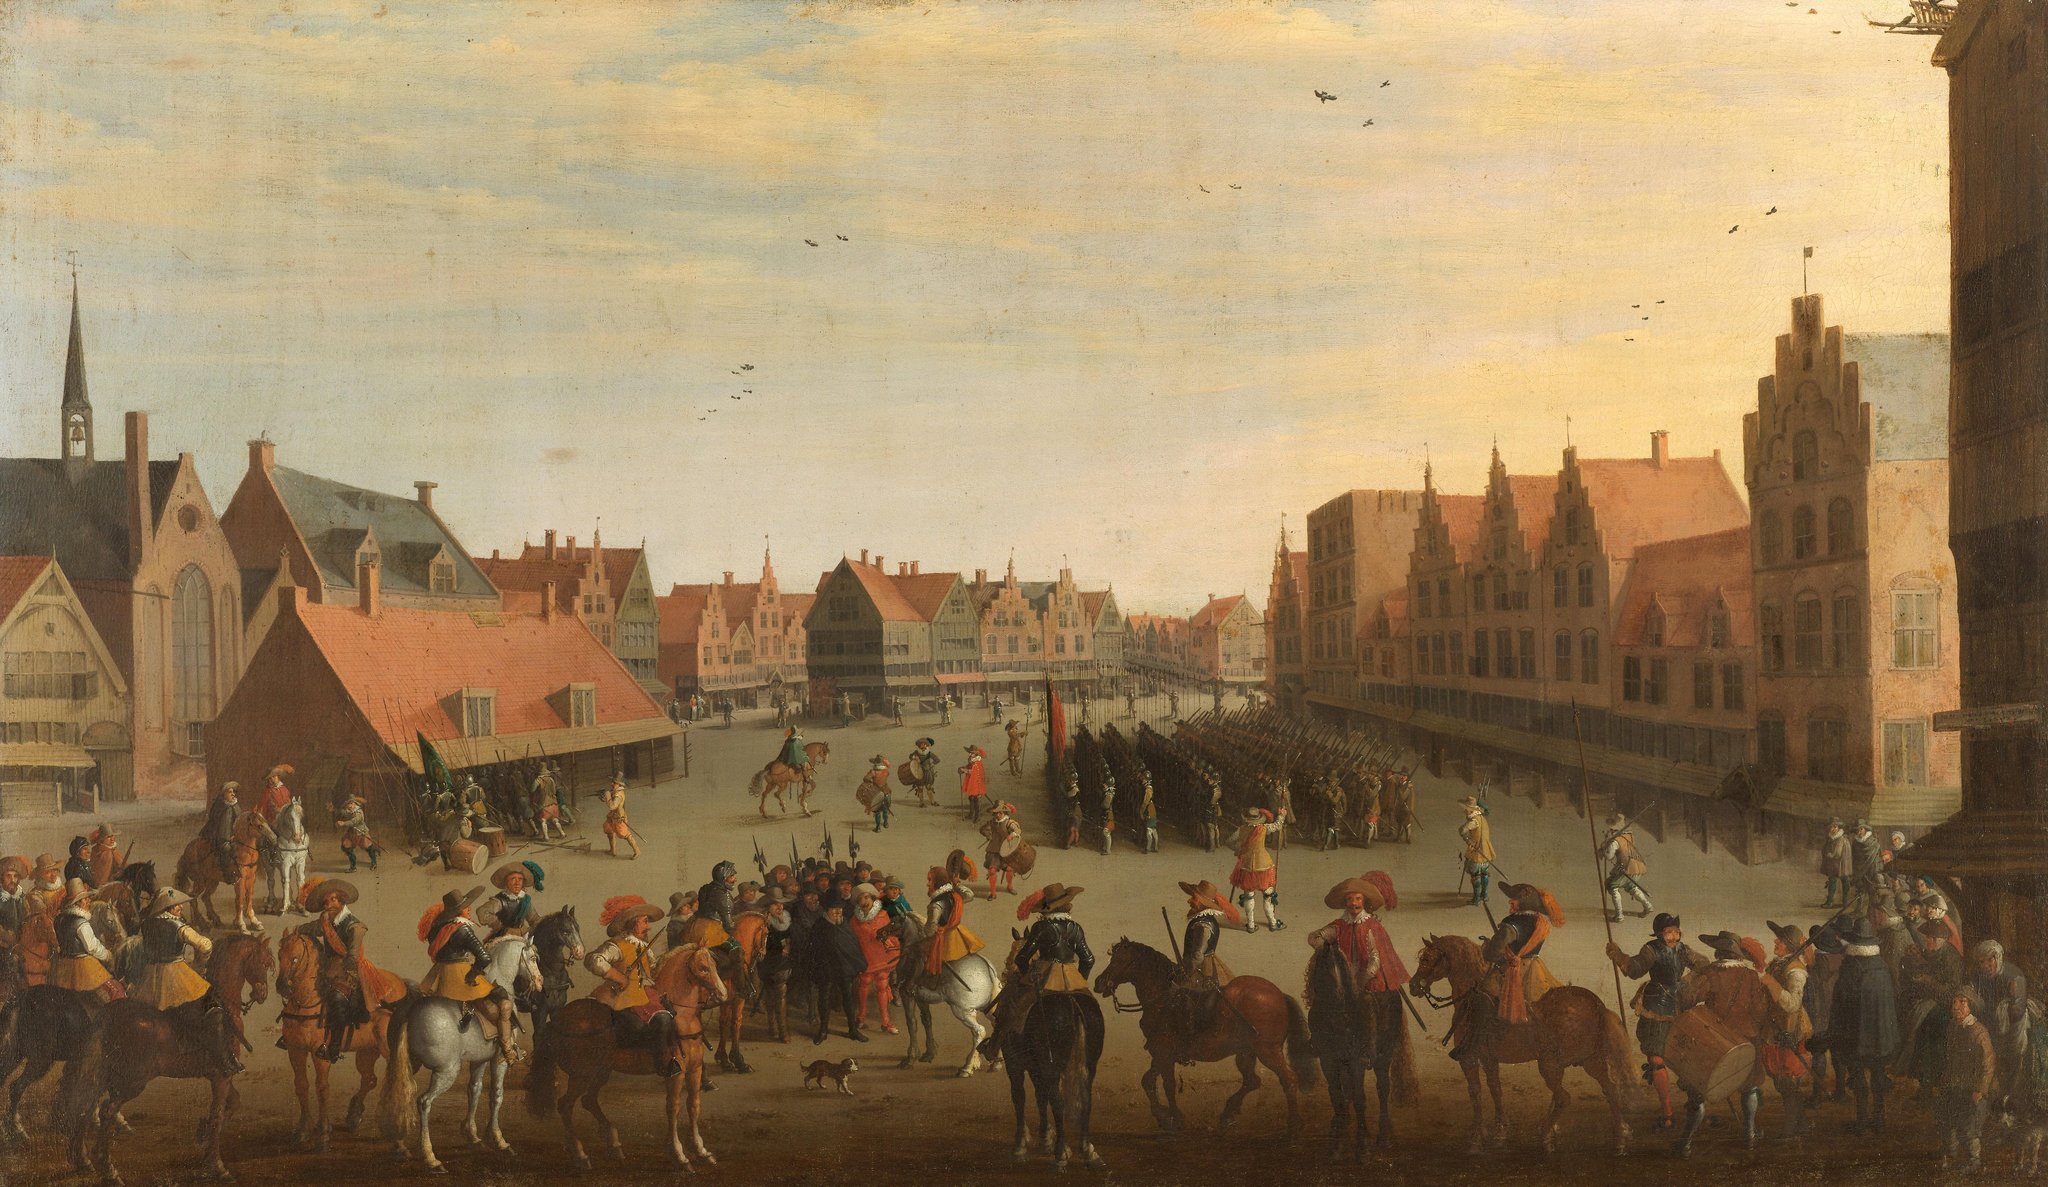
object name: painting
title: The Disbanding of the 'Waardgelders' (Mercenaries in the Pay of the Town Government) by Prince Maurits in Utrecht, 31 July 1618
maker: joost cornelisz droochsloot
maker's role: painter, print maker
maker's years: 1585-1666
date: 1625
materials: canvas, oil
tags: maurice (prince of orange), square, place, circus, etc., disbanding of the troops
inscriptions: signature and date, upper right, on the signboard: ‘Joost. Cornelis. Drooch. Sloot f. An.º. 1625.’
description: Het afdanken der waardgelders door prins Maurits op de Neude te Utrecht, 31 juli 1618. Op de voorgrond de prins begeleid door andere officieren te paard. Op het plein staan de soldaten in rijen opgesteld.